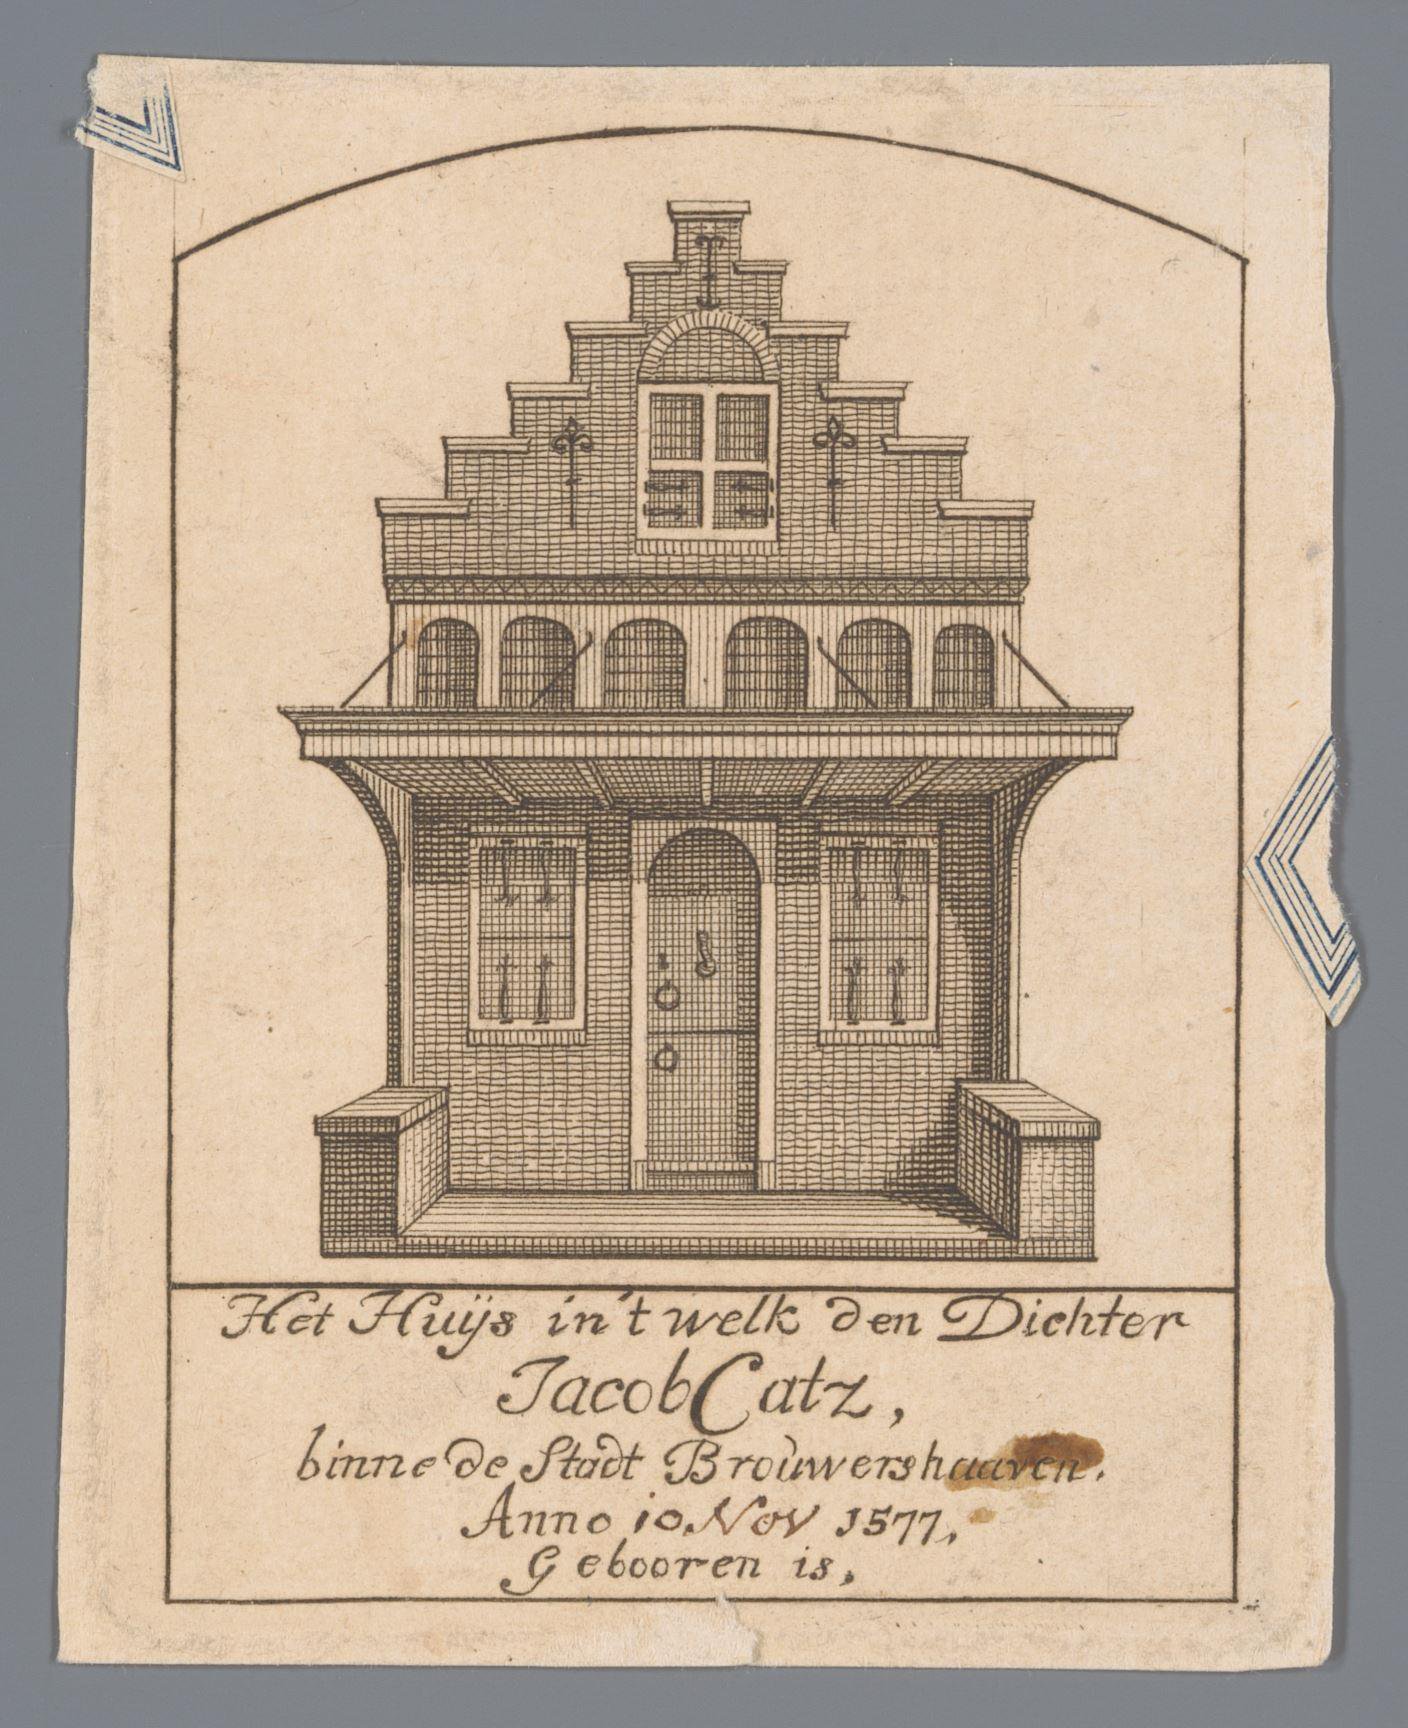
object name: print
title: Het Huijs in 't welk den Dichter Jacob Catz, binne de Stadt Brouwershaaven, Anno 10 Nov 1577, gebooren is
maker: Anonymous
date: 1675-1750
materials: paper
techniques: etching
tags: façade (of house or building)